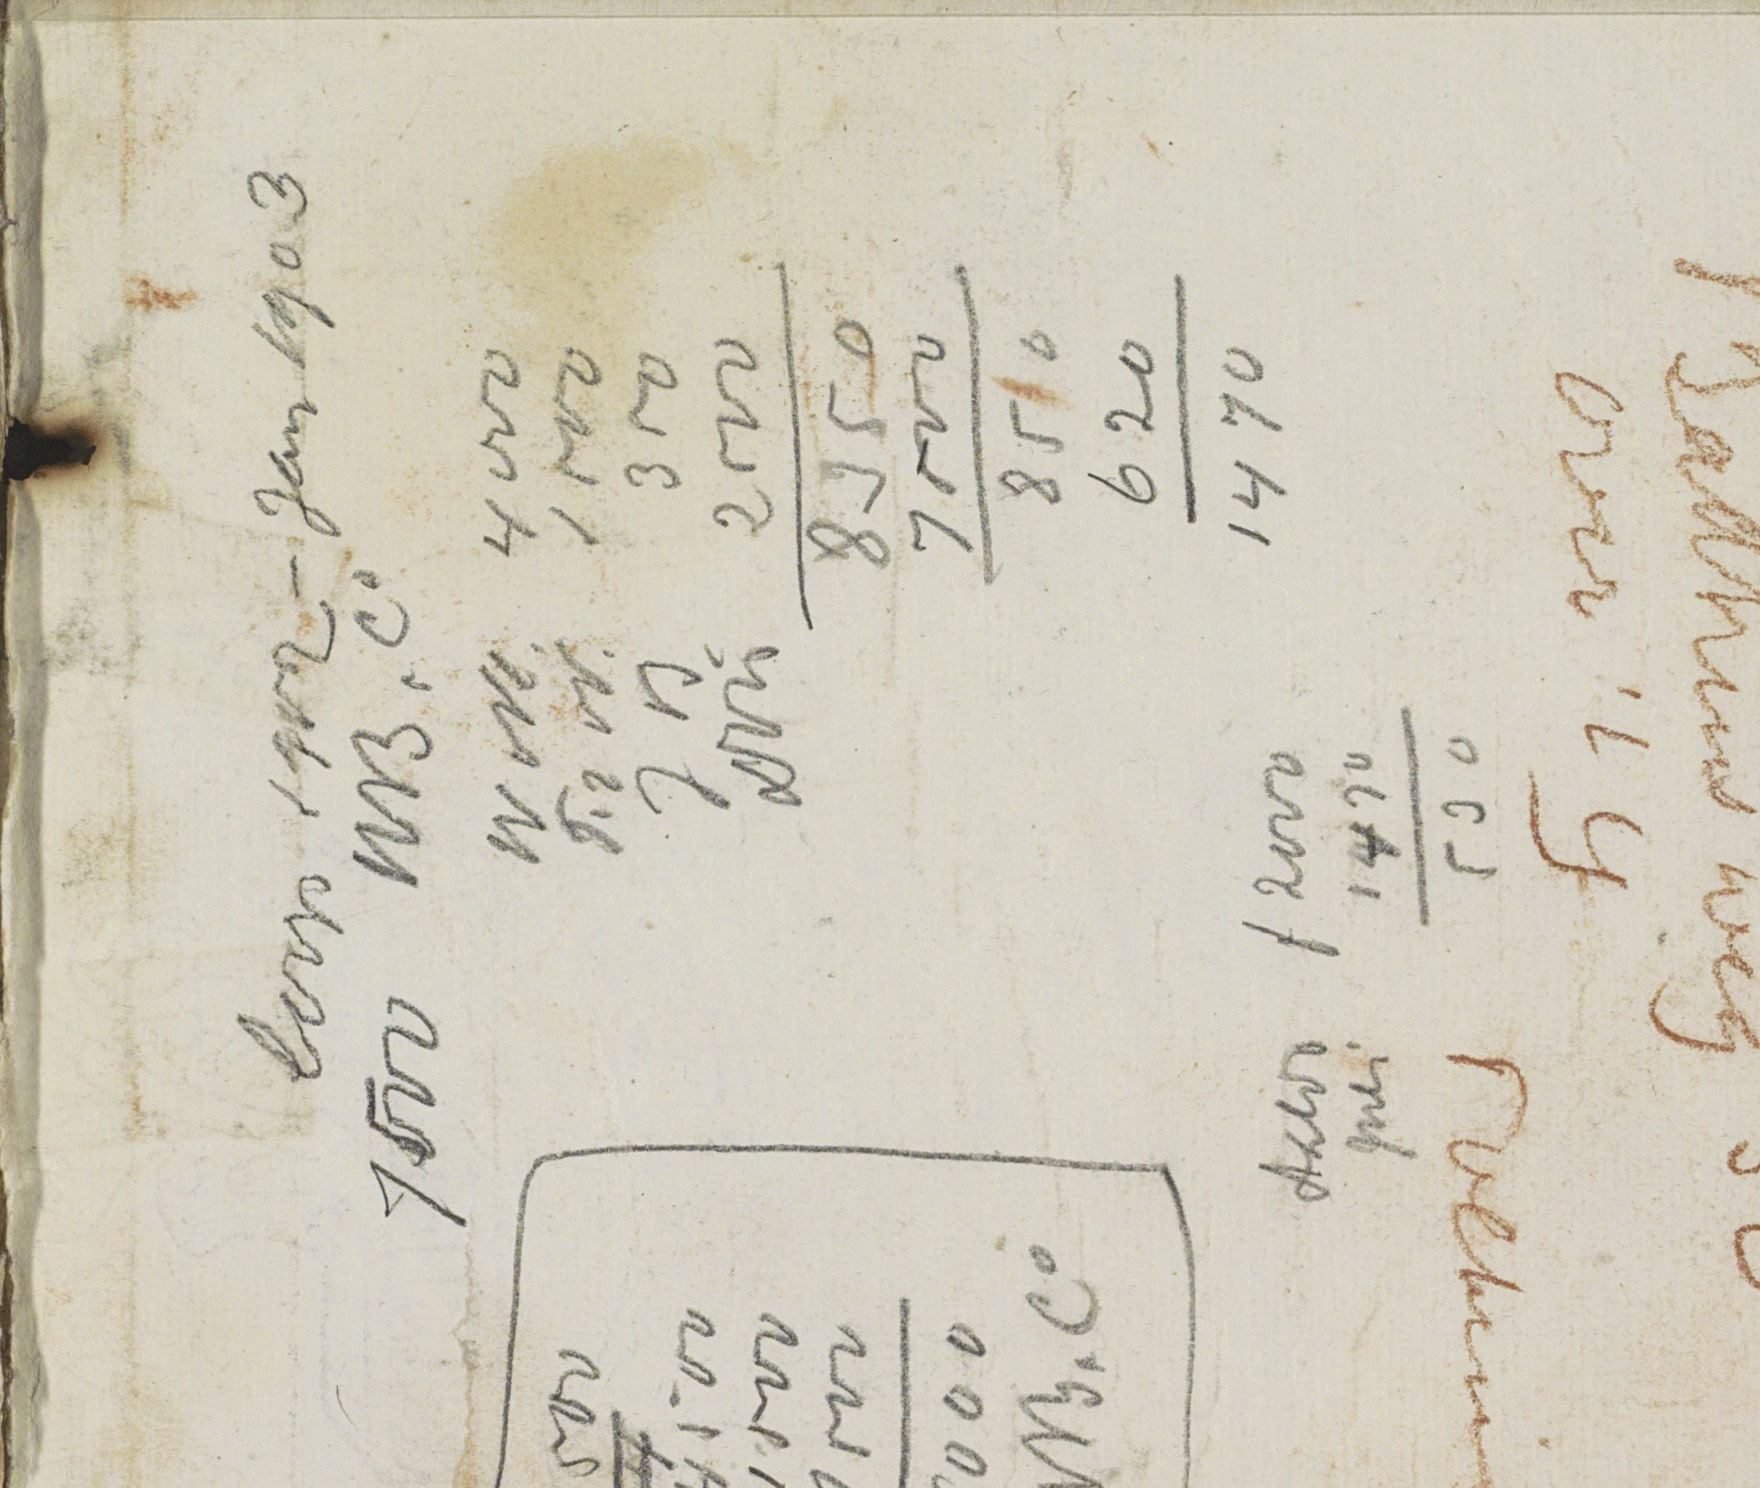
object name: endleaf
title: Annotaties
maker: willem witsen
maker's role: draughtsman, painter, print maker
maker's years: 1860-1923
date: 1915-1920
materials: chalk, paper, pencil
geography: amsterdam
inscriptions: annotation: ‘[...]’, address: ‘Badhuisweg 50/ over 't IJ/ [...]’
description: Schutblad B, achterste schutblad, uit een schetsboek met 12 bladen.